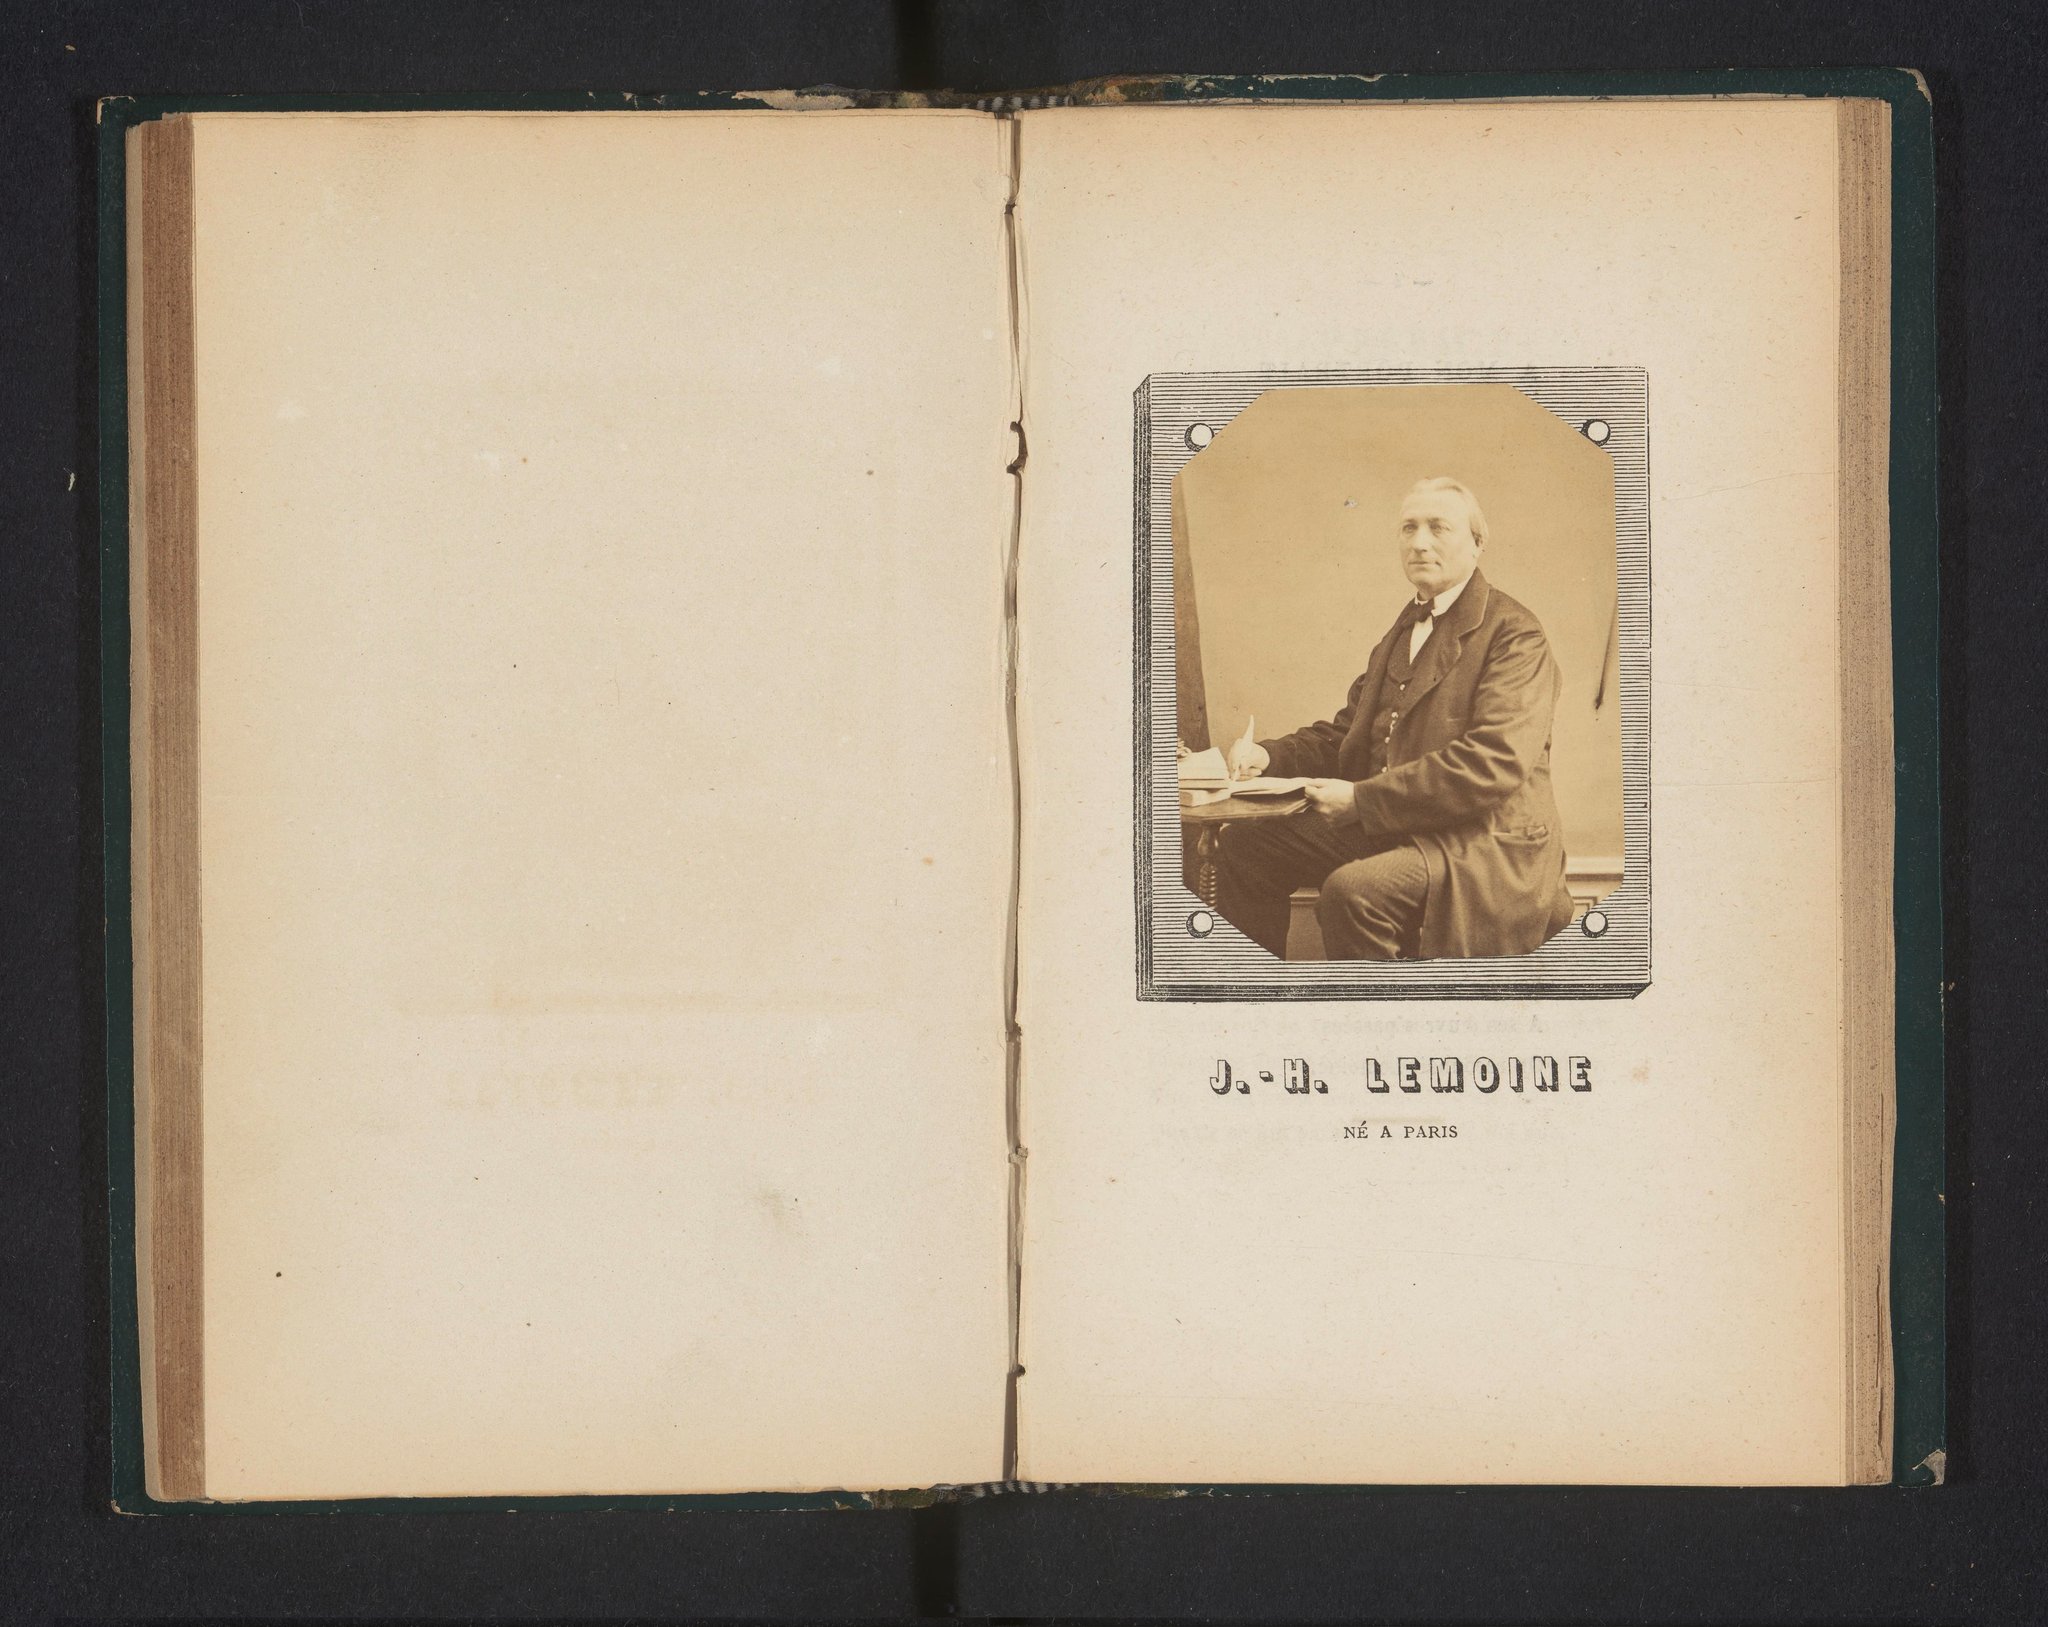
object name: page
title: J.H. Lemoine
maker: Anonymous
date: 1855-1865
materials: photographic support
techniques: albumen print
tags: henry lemoine (componist), composer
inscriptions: inscription: ‘Né a Paris’